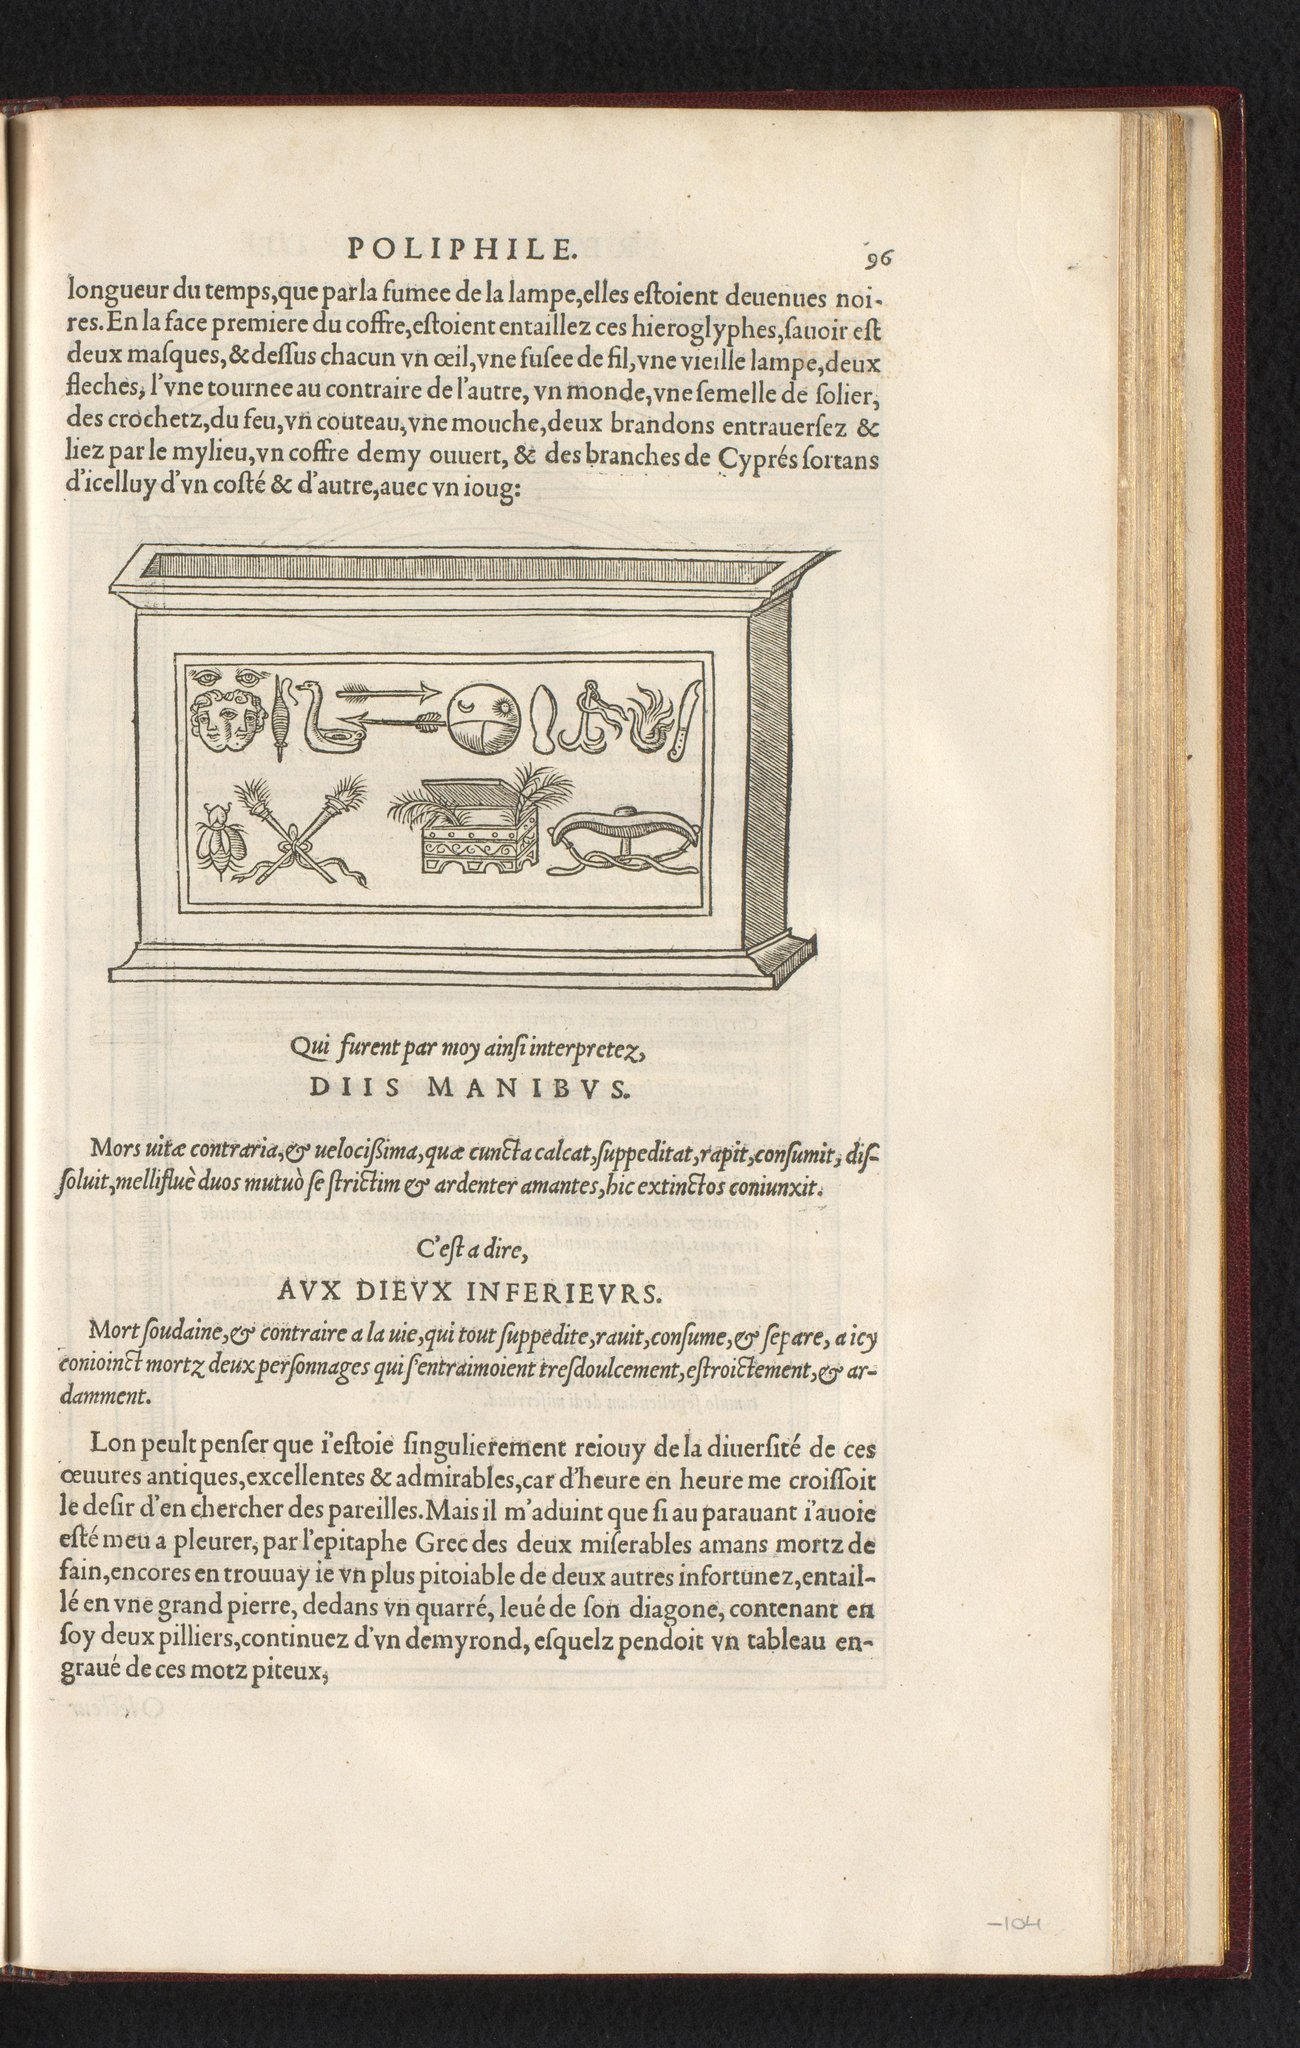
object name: book illustration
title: Stenen kist met rebus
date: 1546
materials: paper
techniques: letterpress printing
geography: paris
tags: (scenes from) specific works of literature: colonna, hypnerotomachia poliphili, rebus, chest, coffer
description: Prent uit: Colonna, Francesco. Hypnerotomachie ou discours du songe de Poliphile, deduisant comme amour le combat a l'occasion de Polia. Parijs: Jacques Kerver, 1546, recto fol. 96.